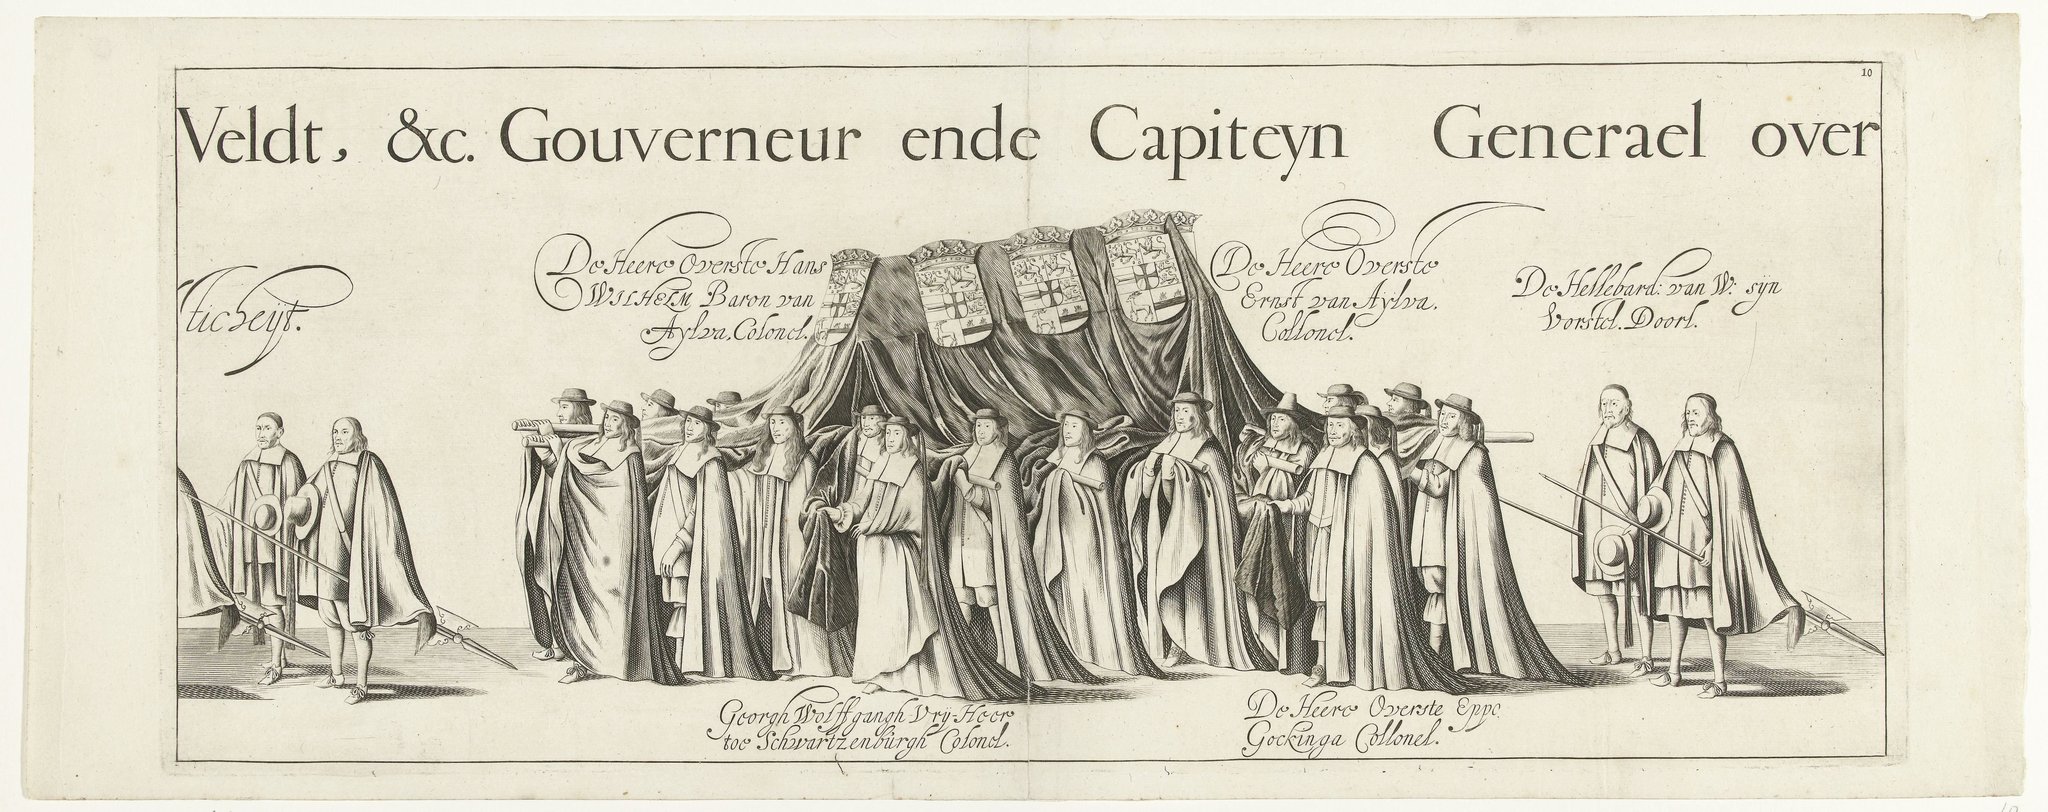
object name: print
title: Rouw-Staetelijcke Lijk-pracht in de Uyt-Vaert en Begraefenisse van het ont-zielde Lichaem van (...) Wilhelm Frederich (...) Overleden binnen Leeuwarden (...) den een-en-twintichsten October, MDCLXIV. en aldaer in 't Choor van de Jacobijner Kerck, den vyfthienden december MDCLXIV. Oude Stijl (...)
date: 1666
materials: paper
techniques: engraving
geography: leeuwarden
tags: cortege, funeral procession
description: Begrafenisoptocht van Willem Frederik, graaf van Nassau-Dietz, in Leeuwarden op 6 januari 1665. Deel van de begrafenisstoet met de lijkkist. Plaat nr. 10 in een ensemble van 25 ongemonteerde genummerde platen en twee tekstbladen die samen een lange fries vormen.